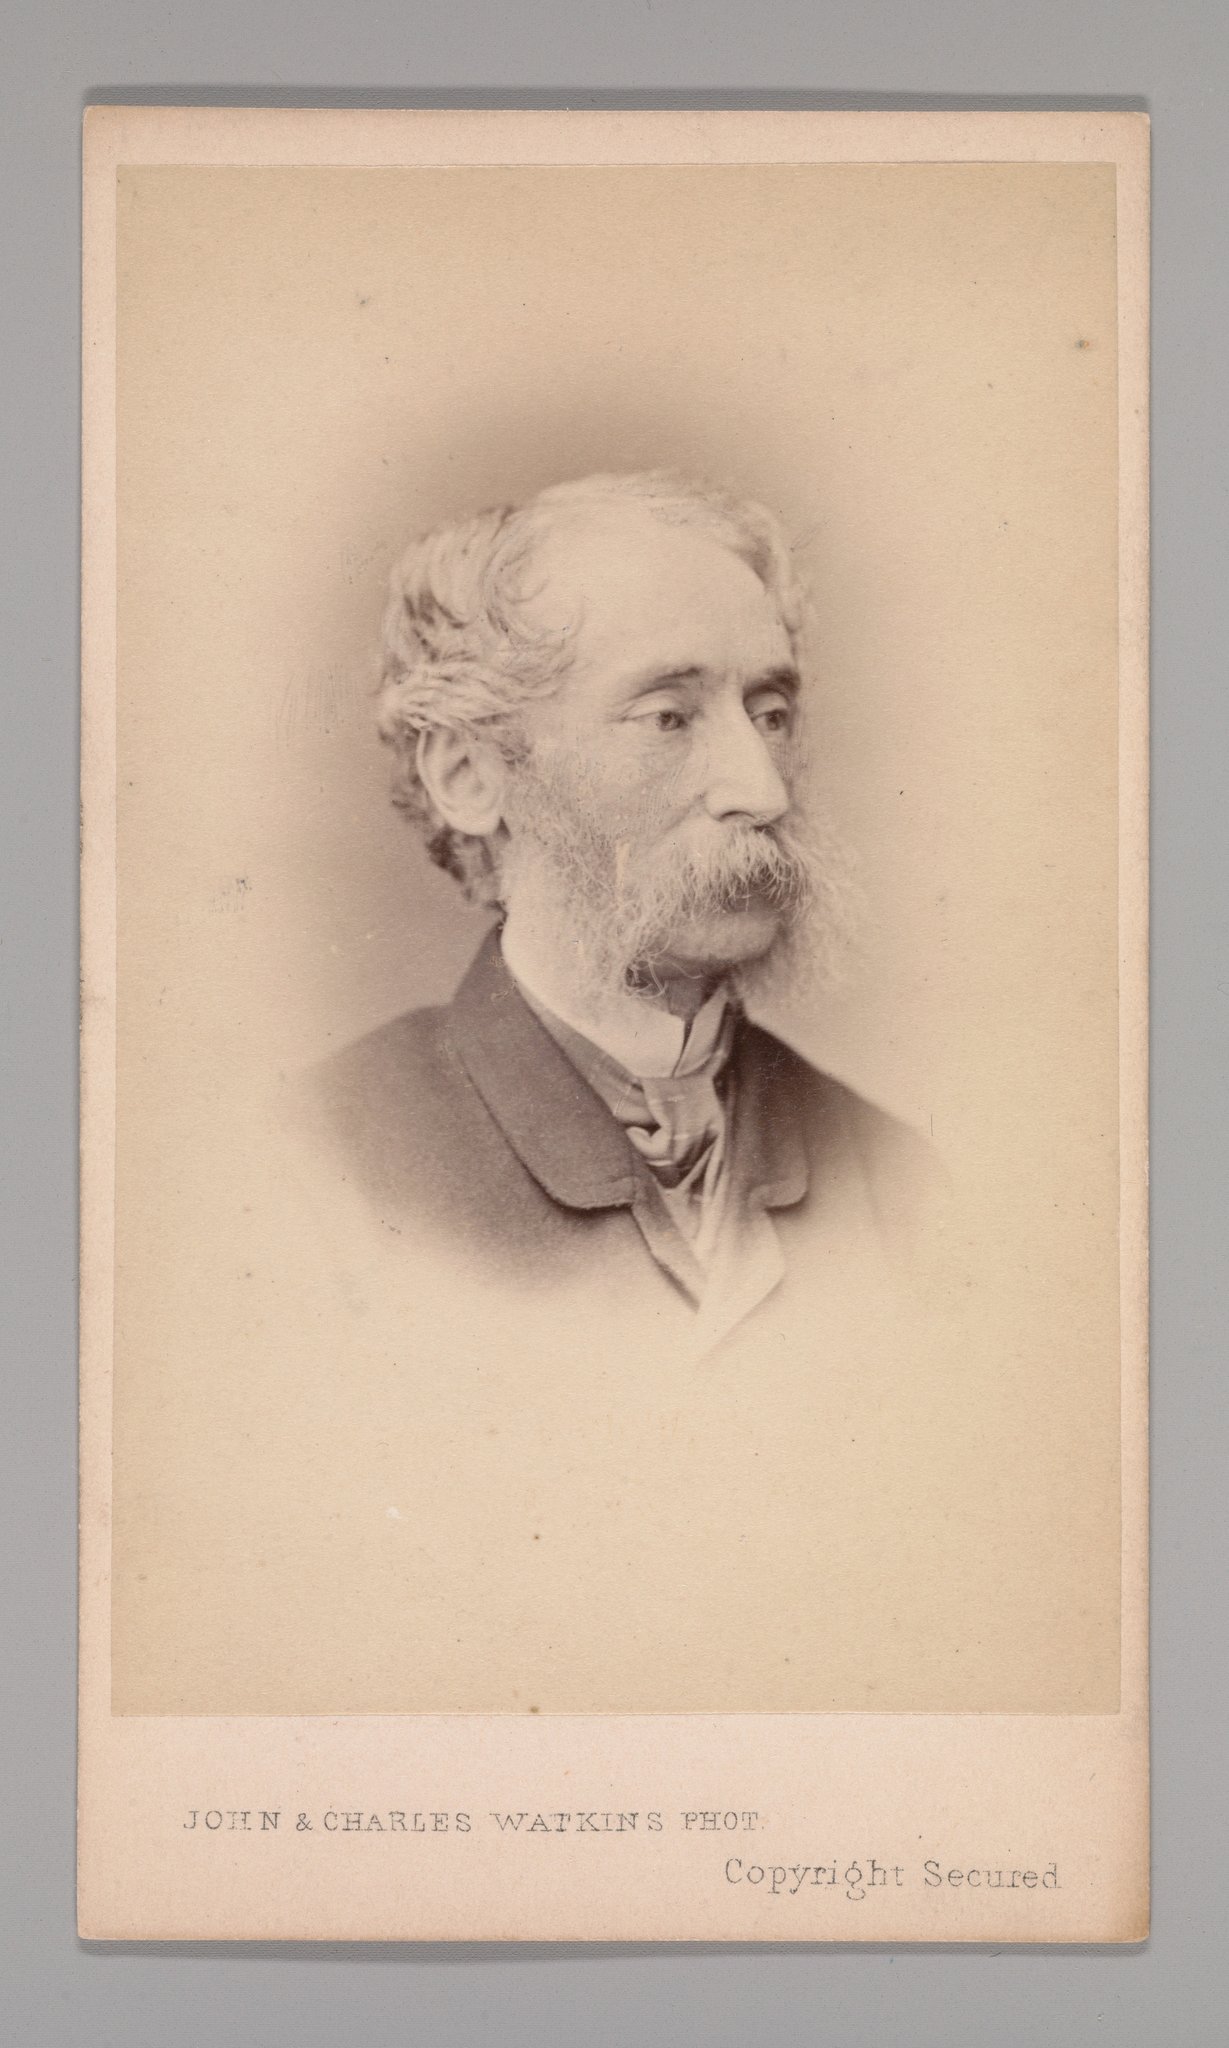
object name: carte de visite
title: [John Ballantyne]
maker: john and charles watkins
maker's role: photography studio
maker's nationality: british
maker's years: 1840-1875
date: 1860-1869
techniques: albumen silver print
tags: men,portraits